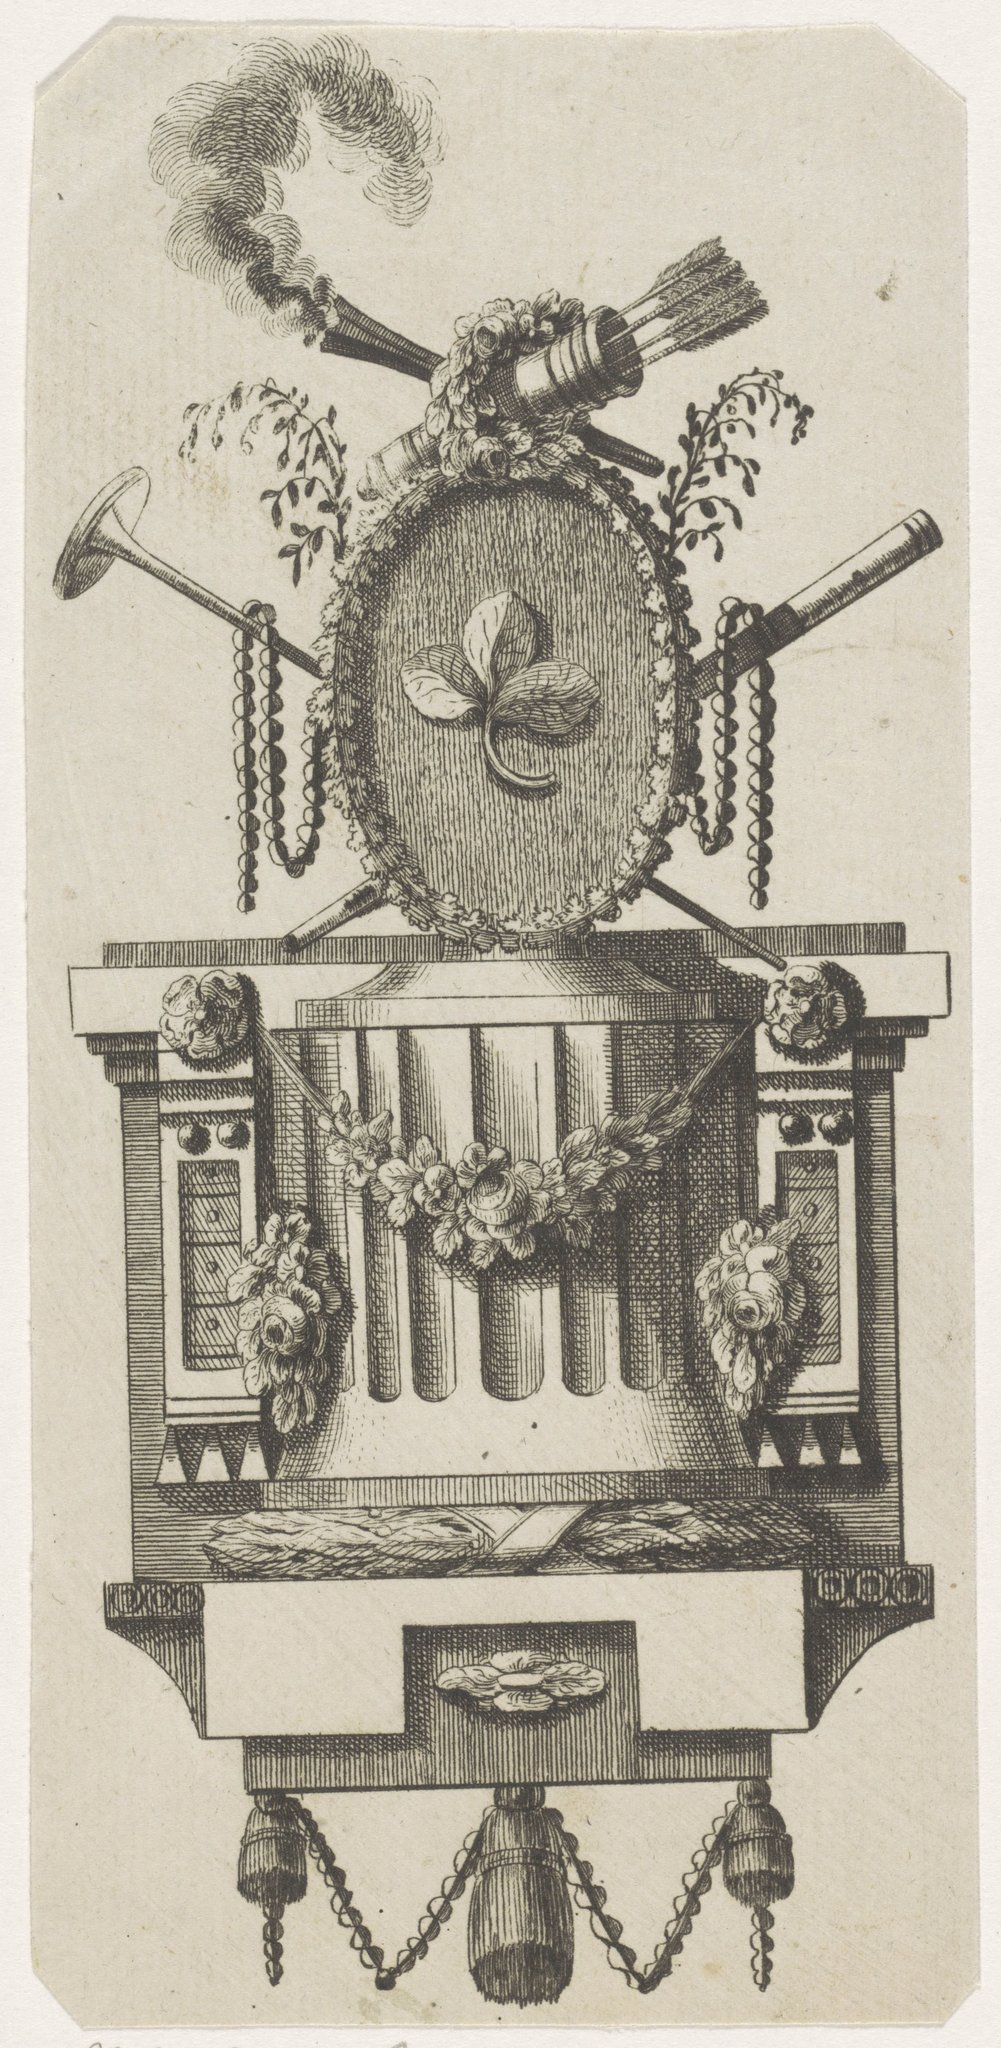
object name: print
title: Trofee met zuil, toorts en pijlenkoker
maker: Anonymous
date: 1700-1800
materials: paper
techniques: etching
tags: ornaments ~ art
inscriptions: collector's mark: Lugt 2228